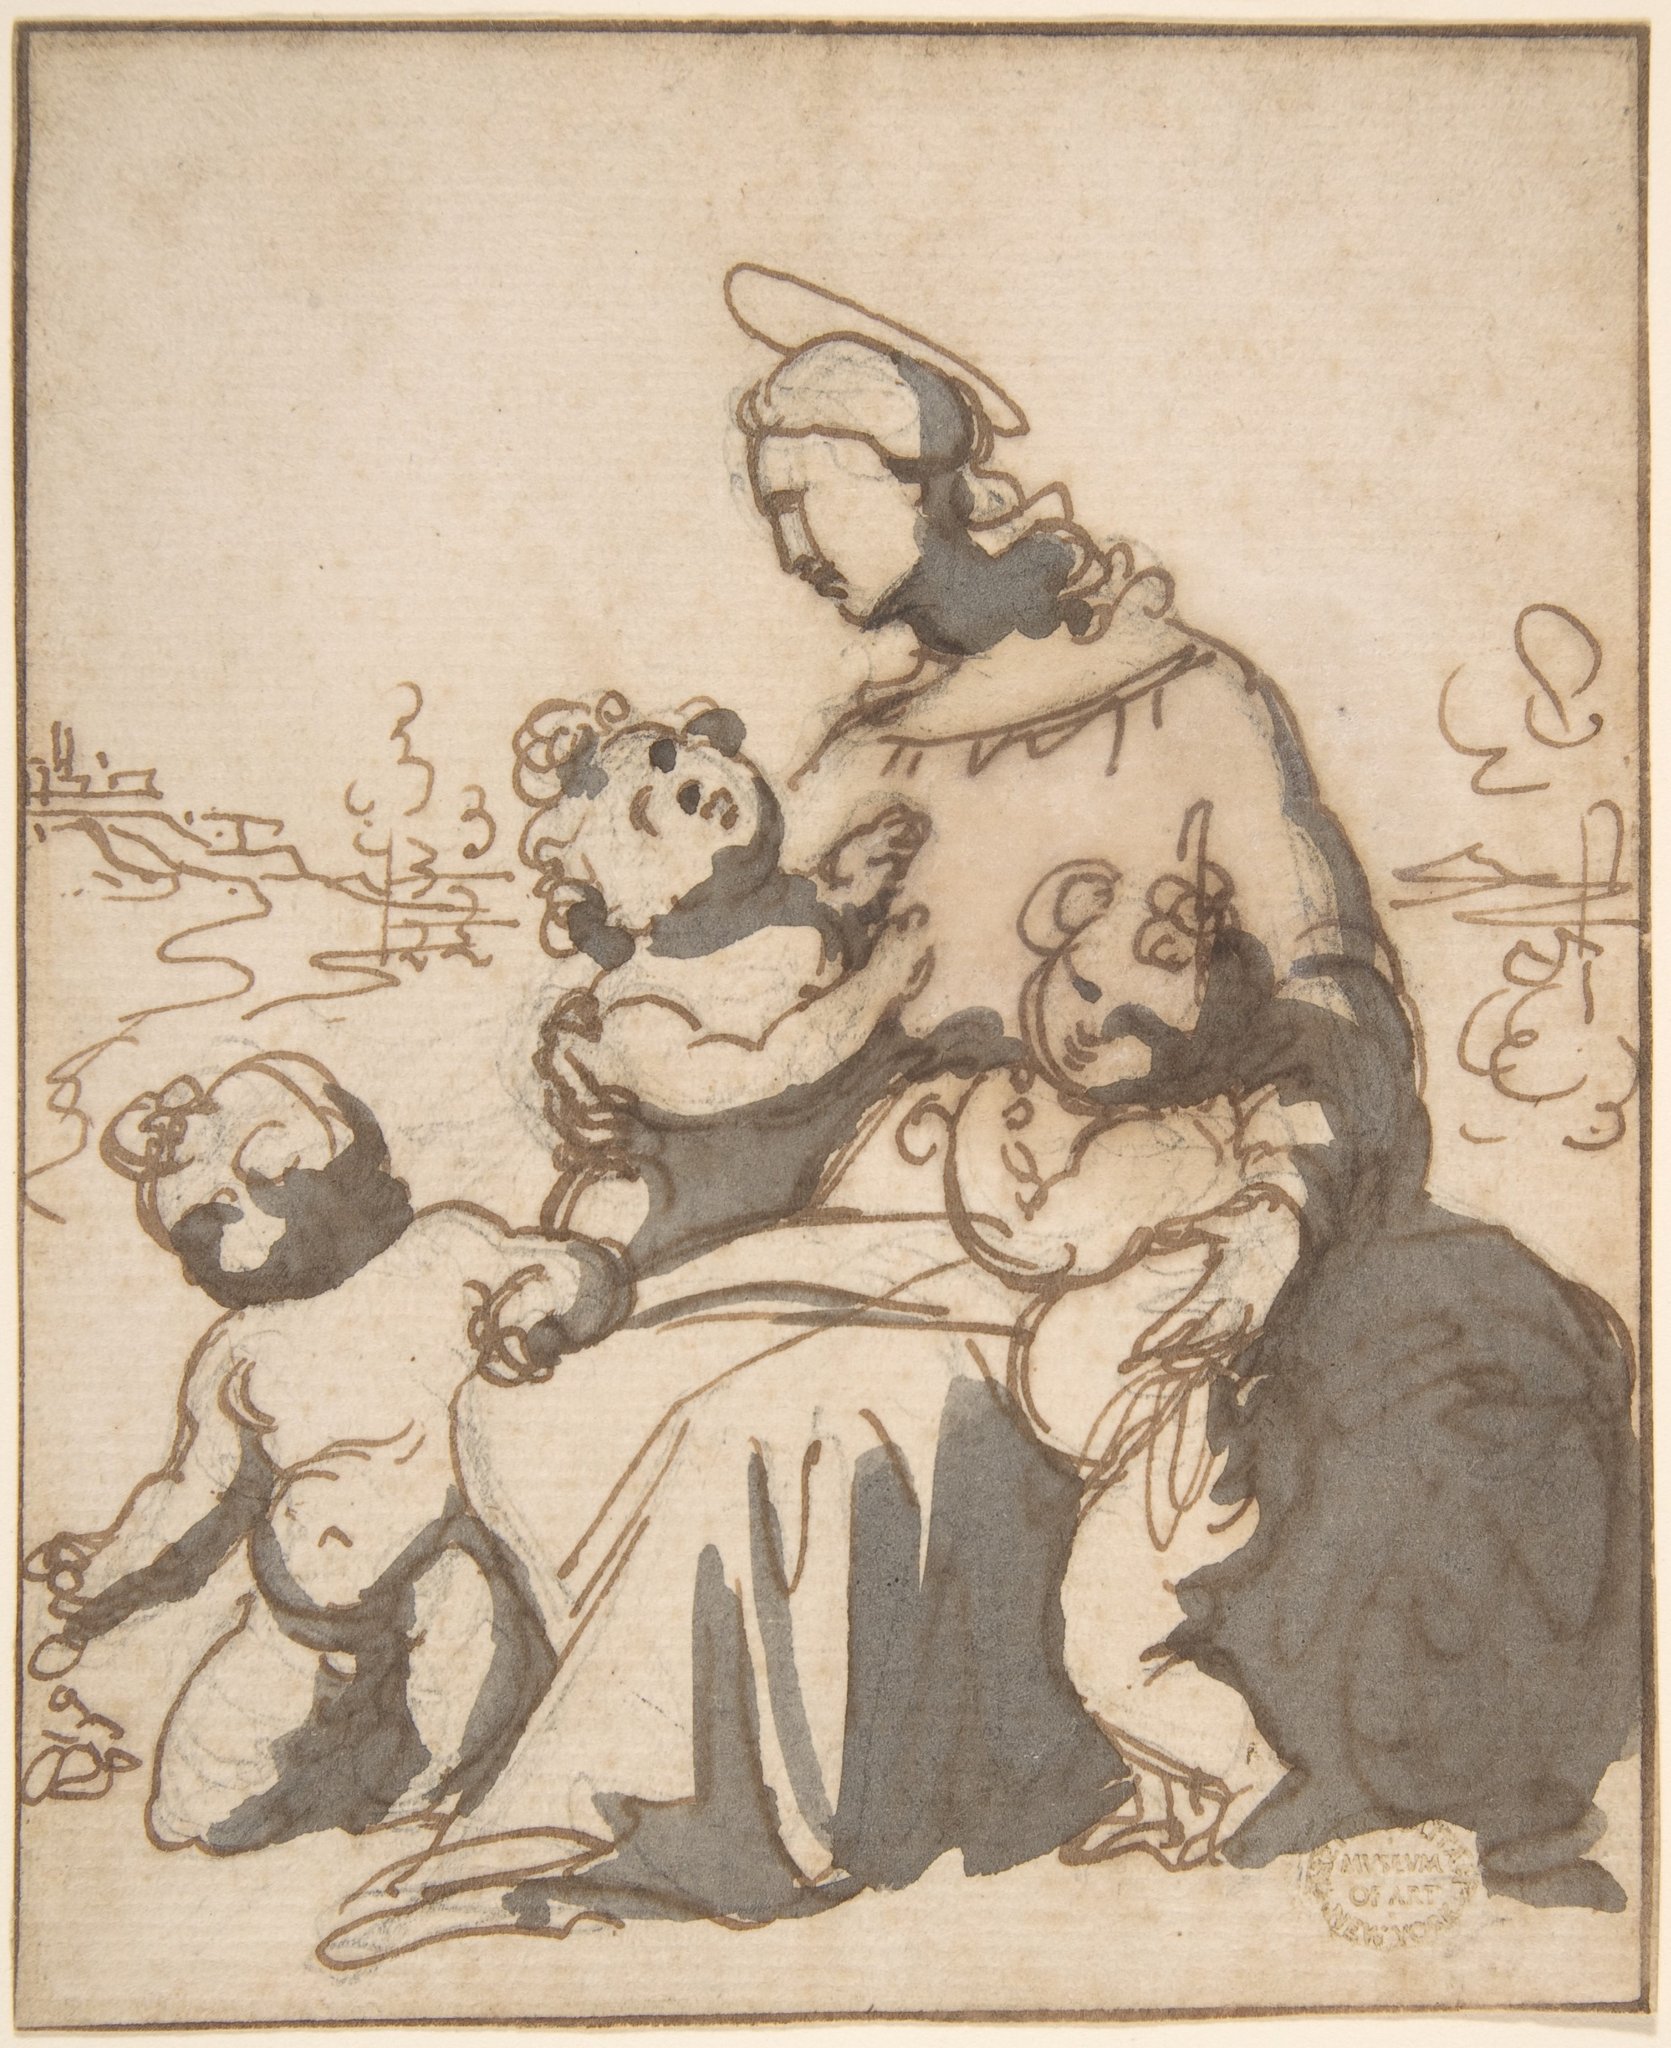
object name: drawing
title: Madonna and Children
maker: anonymous, italian, 16th century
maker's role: artist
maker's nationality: italian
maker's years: 1550-1600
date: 1501-1600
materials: chalk, ink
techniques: brush, pen, wash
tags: madonna and child